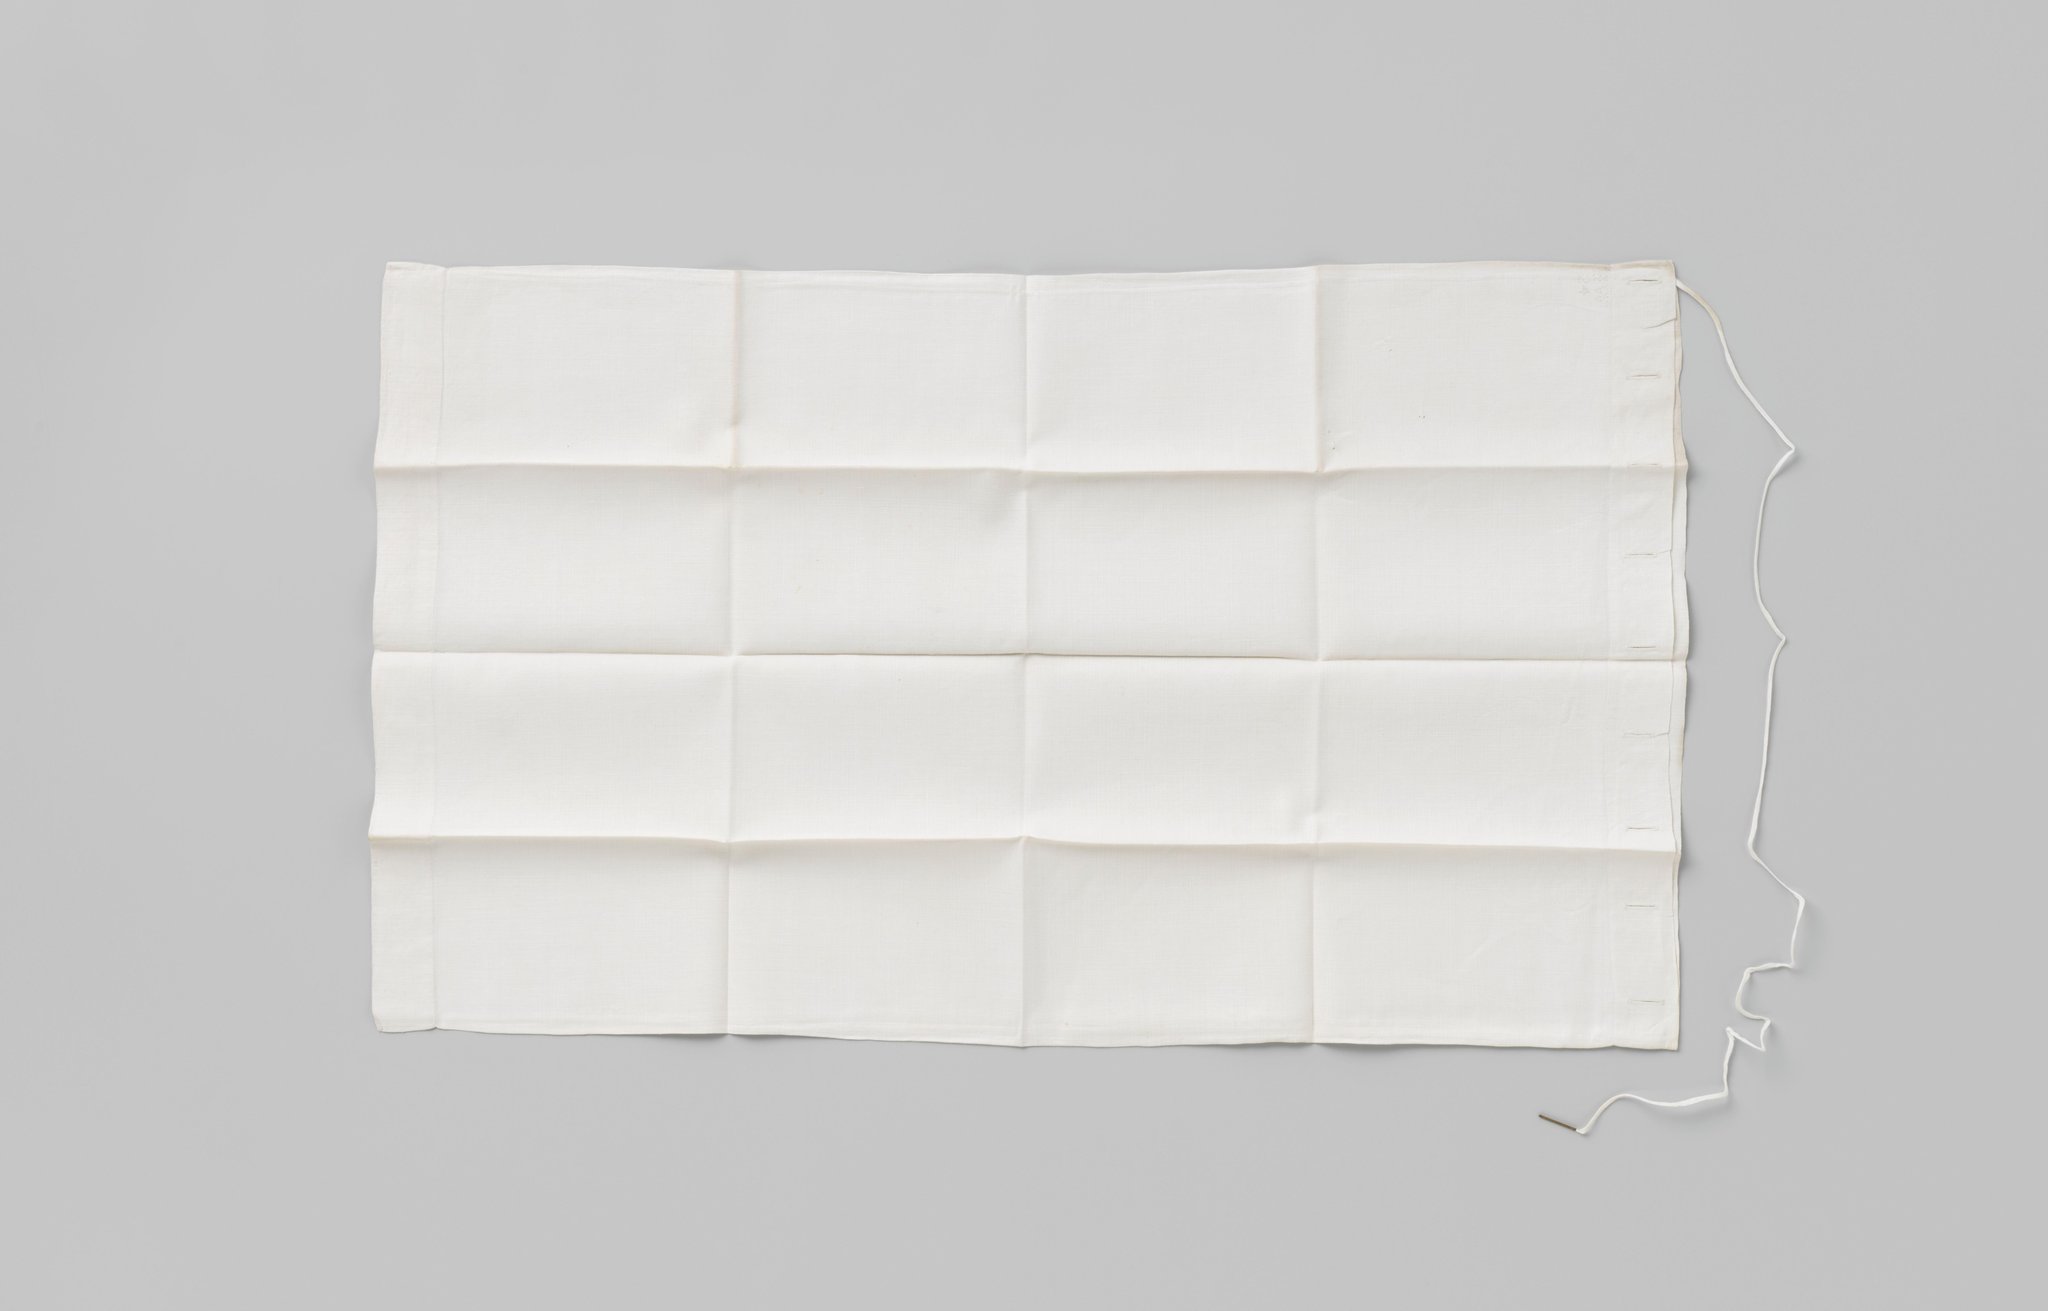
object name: bed covering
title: Lendensloop met merk HW 24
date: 1820-1850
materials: linen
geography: northern netherlands